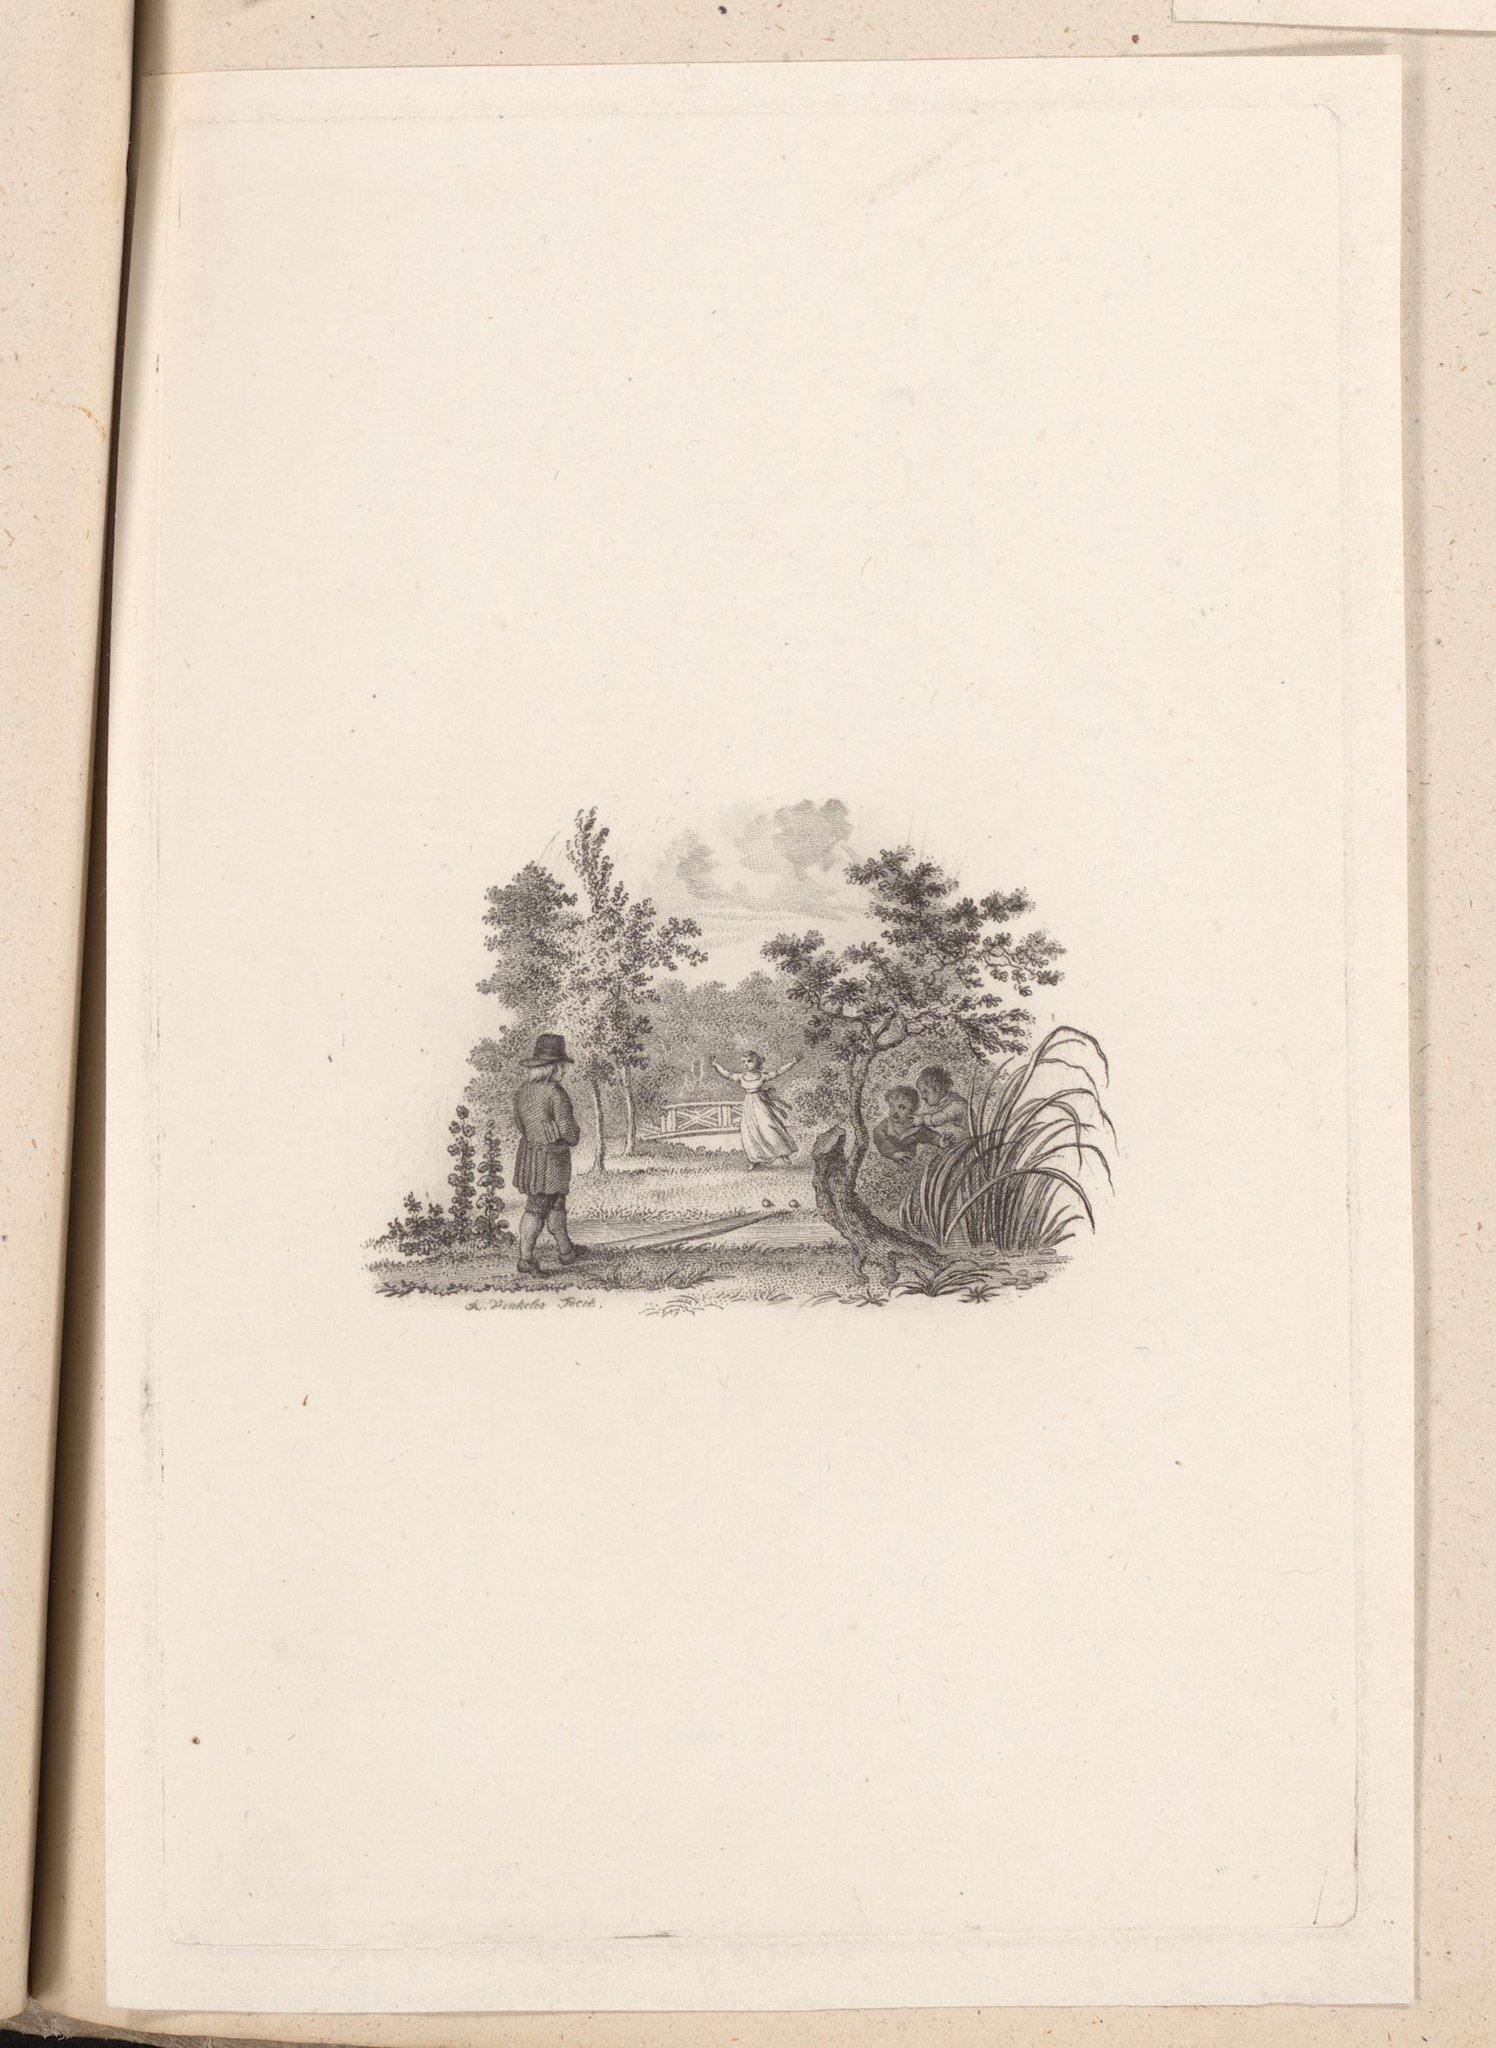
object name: album leaf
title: Landschap waarin een man wordt begroet door een jonge vrouw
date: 1771-1818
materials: paper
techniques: engraving, etching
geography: haarlem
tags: being welcomed ~ travelling, landscapes - hh - ideal landscapes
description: In een landschap rent een jonge dame haar vader of vriend tegemoet. Hij heeft een boek onder zijn arm en wil over een plank de rivier oversteken. Rechts twee kinderen. De prent maakt deel uit van een album.